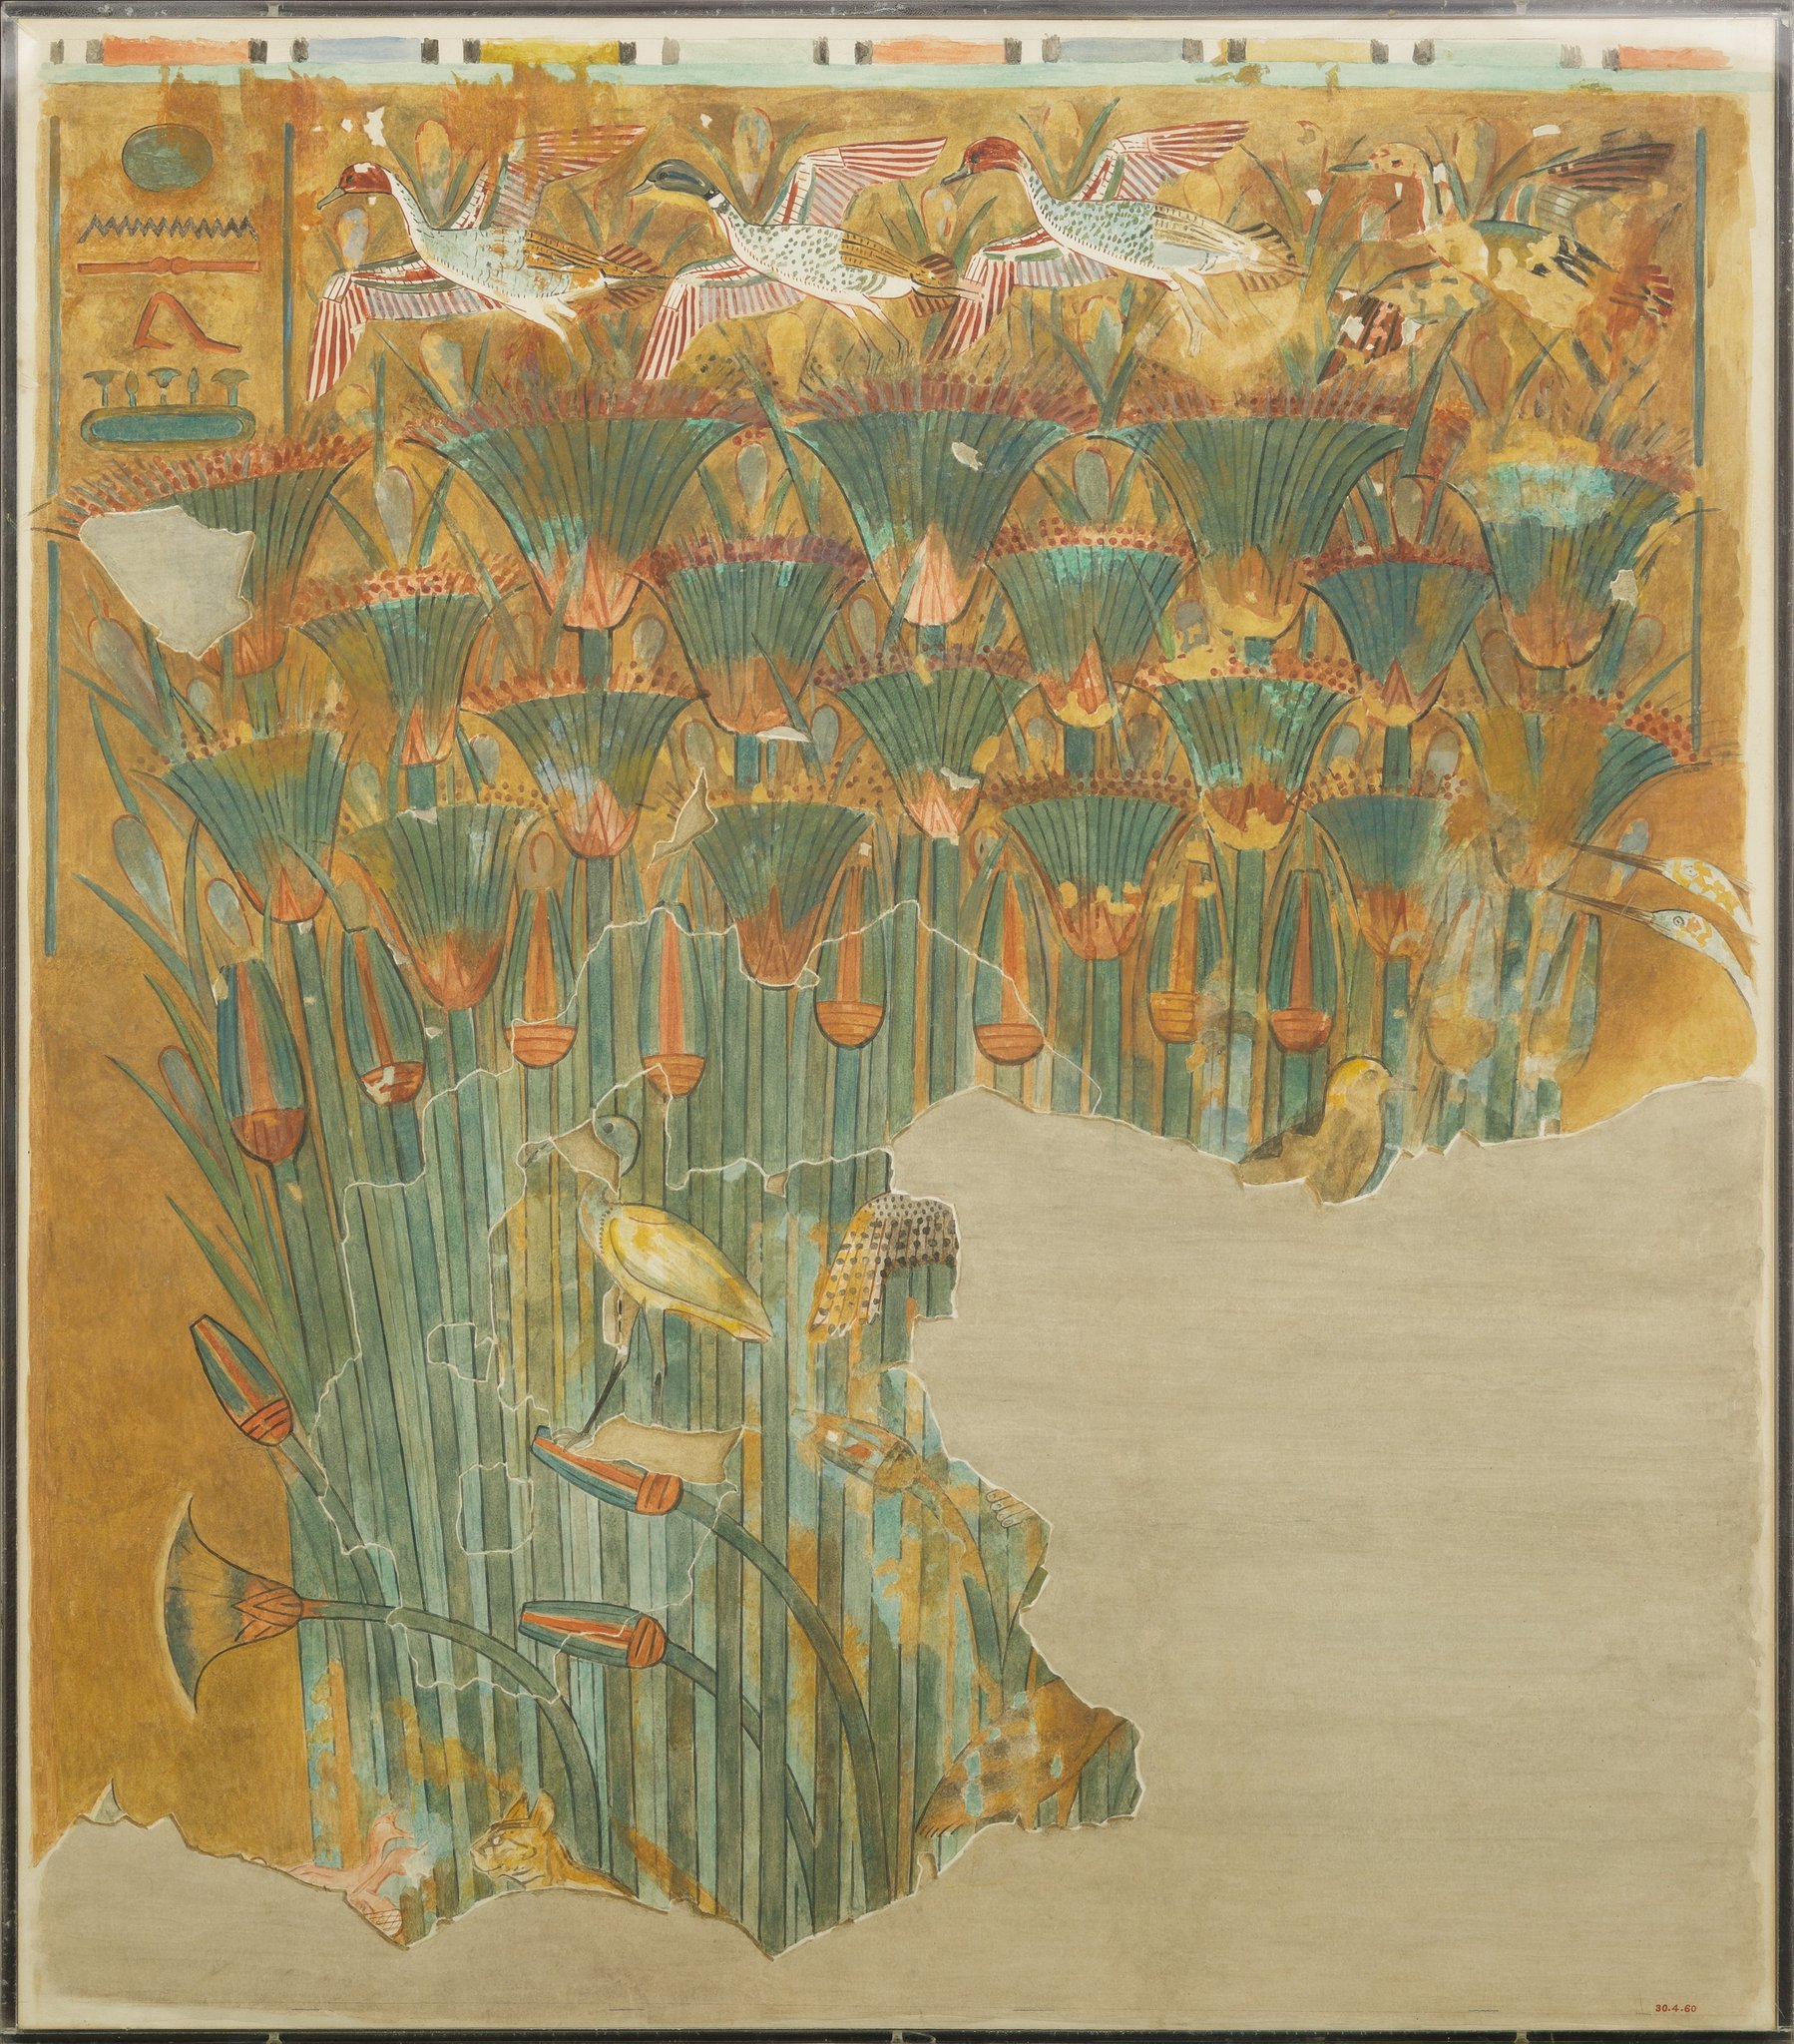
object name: facsimile, qenamun tt 93, marsh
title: Papyrus Marsh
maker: hugh r. hopgood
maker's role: artist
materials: paper, paint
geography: egypt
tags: birds,ducks,plants